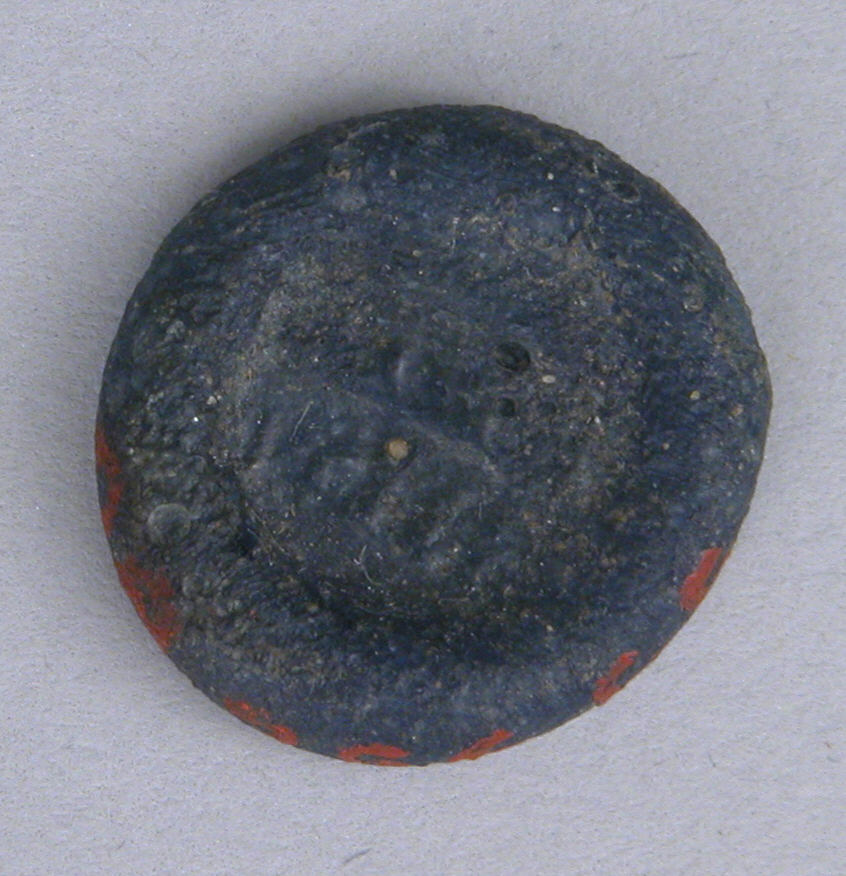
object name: coin weight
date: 901-1200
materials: glass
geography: egypt